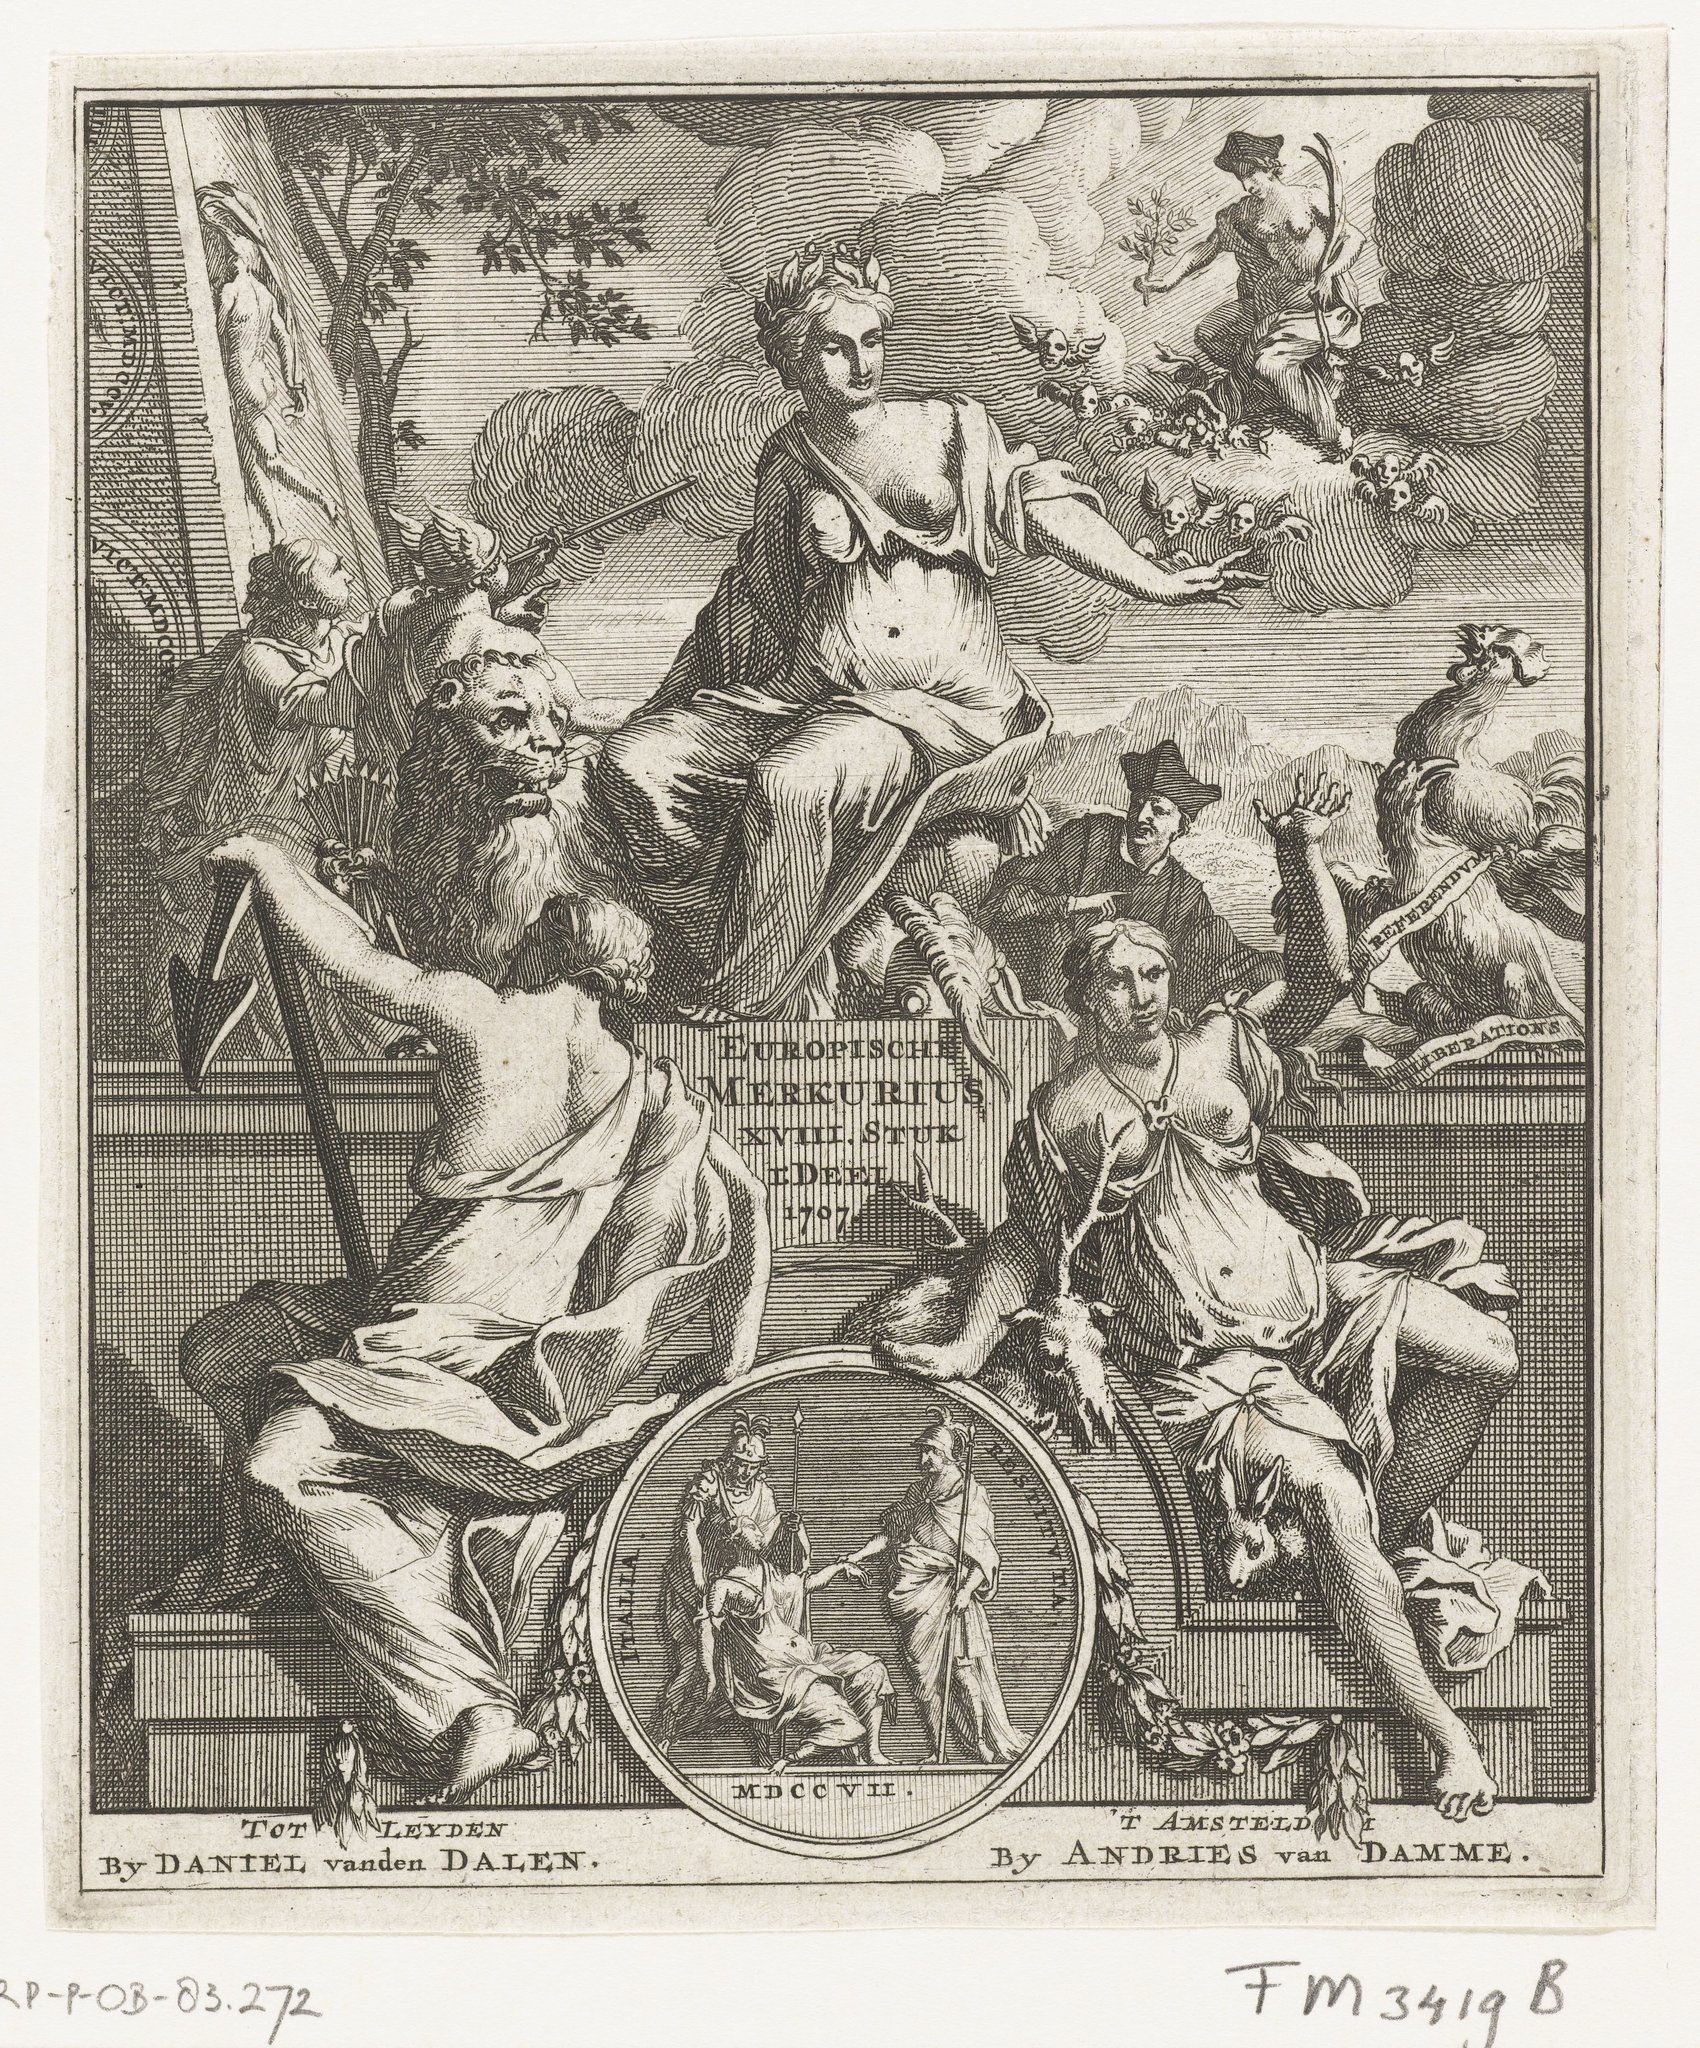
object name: titelblad, titelpagina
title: Titelpagina voor de Europische Mercurius voor het jaar 1707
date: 1707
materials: paper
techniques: engraving, etching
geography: amsterdam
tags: spaanse successieoorlog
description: Titelpagina voor de Europische Mercurius, dl. XVIII, eerste deel van 1707. Allegorische vrouwenfiguur (Overwinning of Eer) zittend op een voetstuk, aan haar voeten de Nederlandse Leeuw. Op de voorgrond de Hoop en de godin Diana (?) bij een embleem van Italia Restituta.